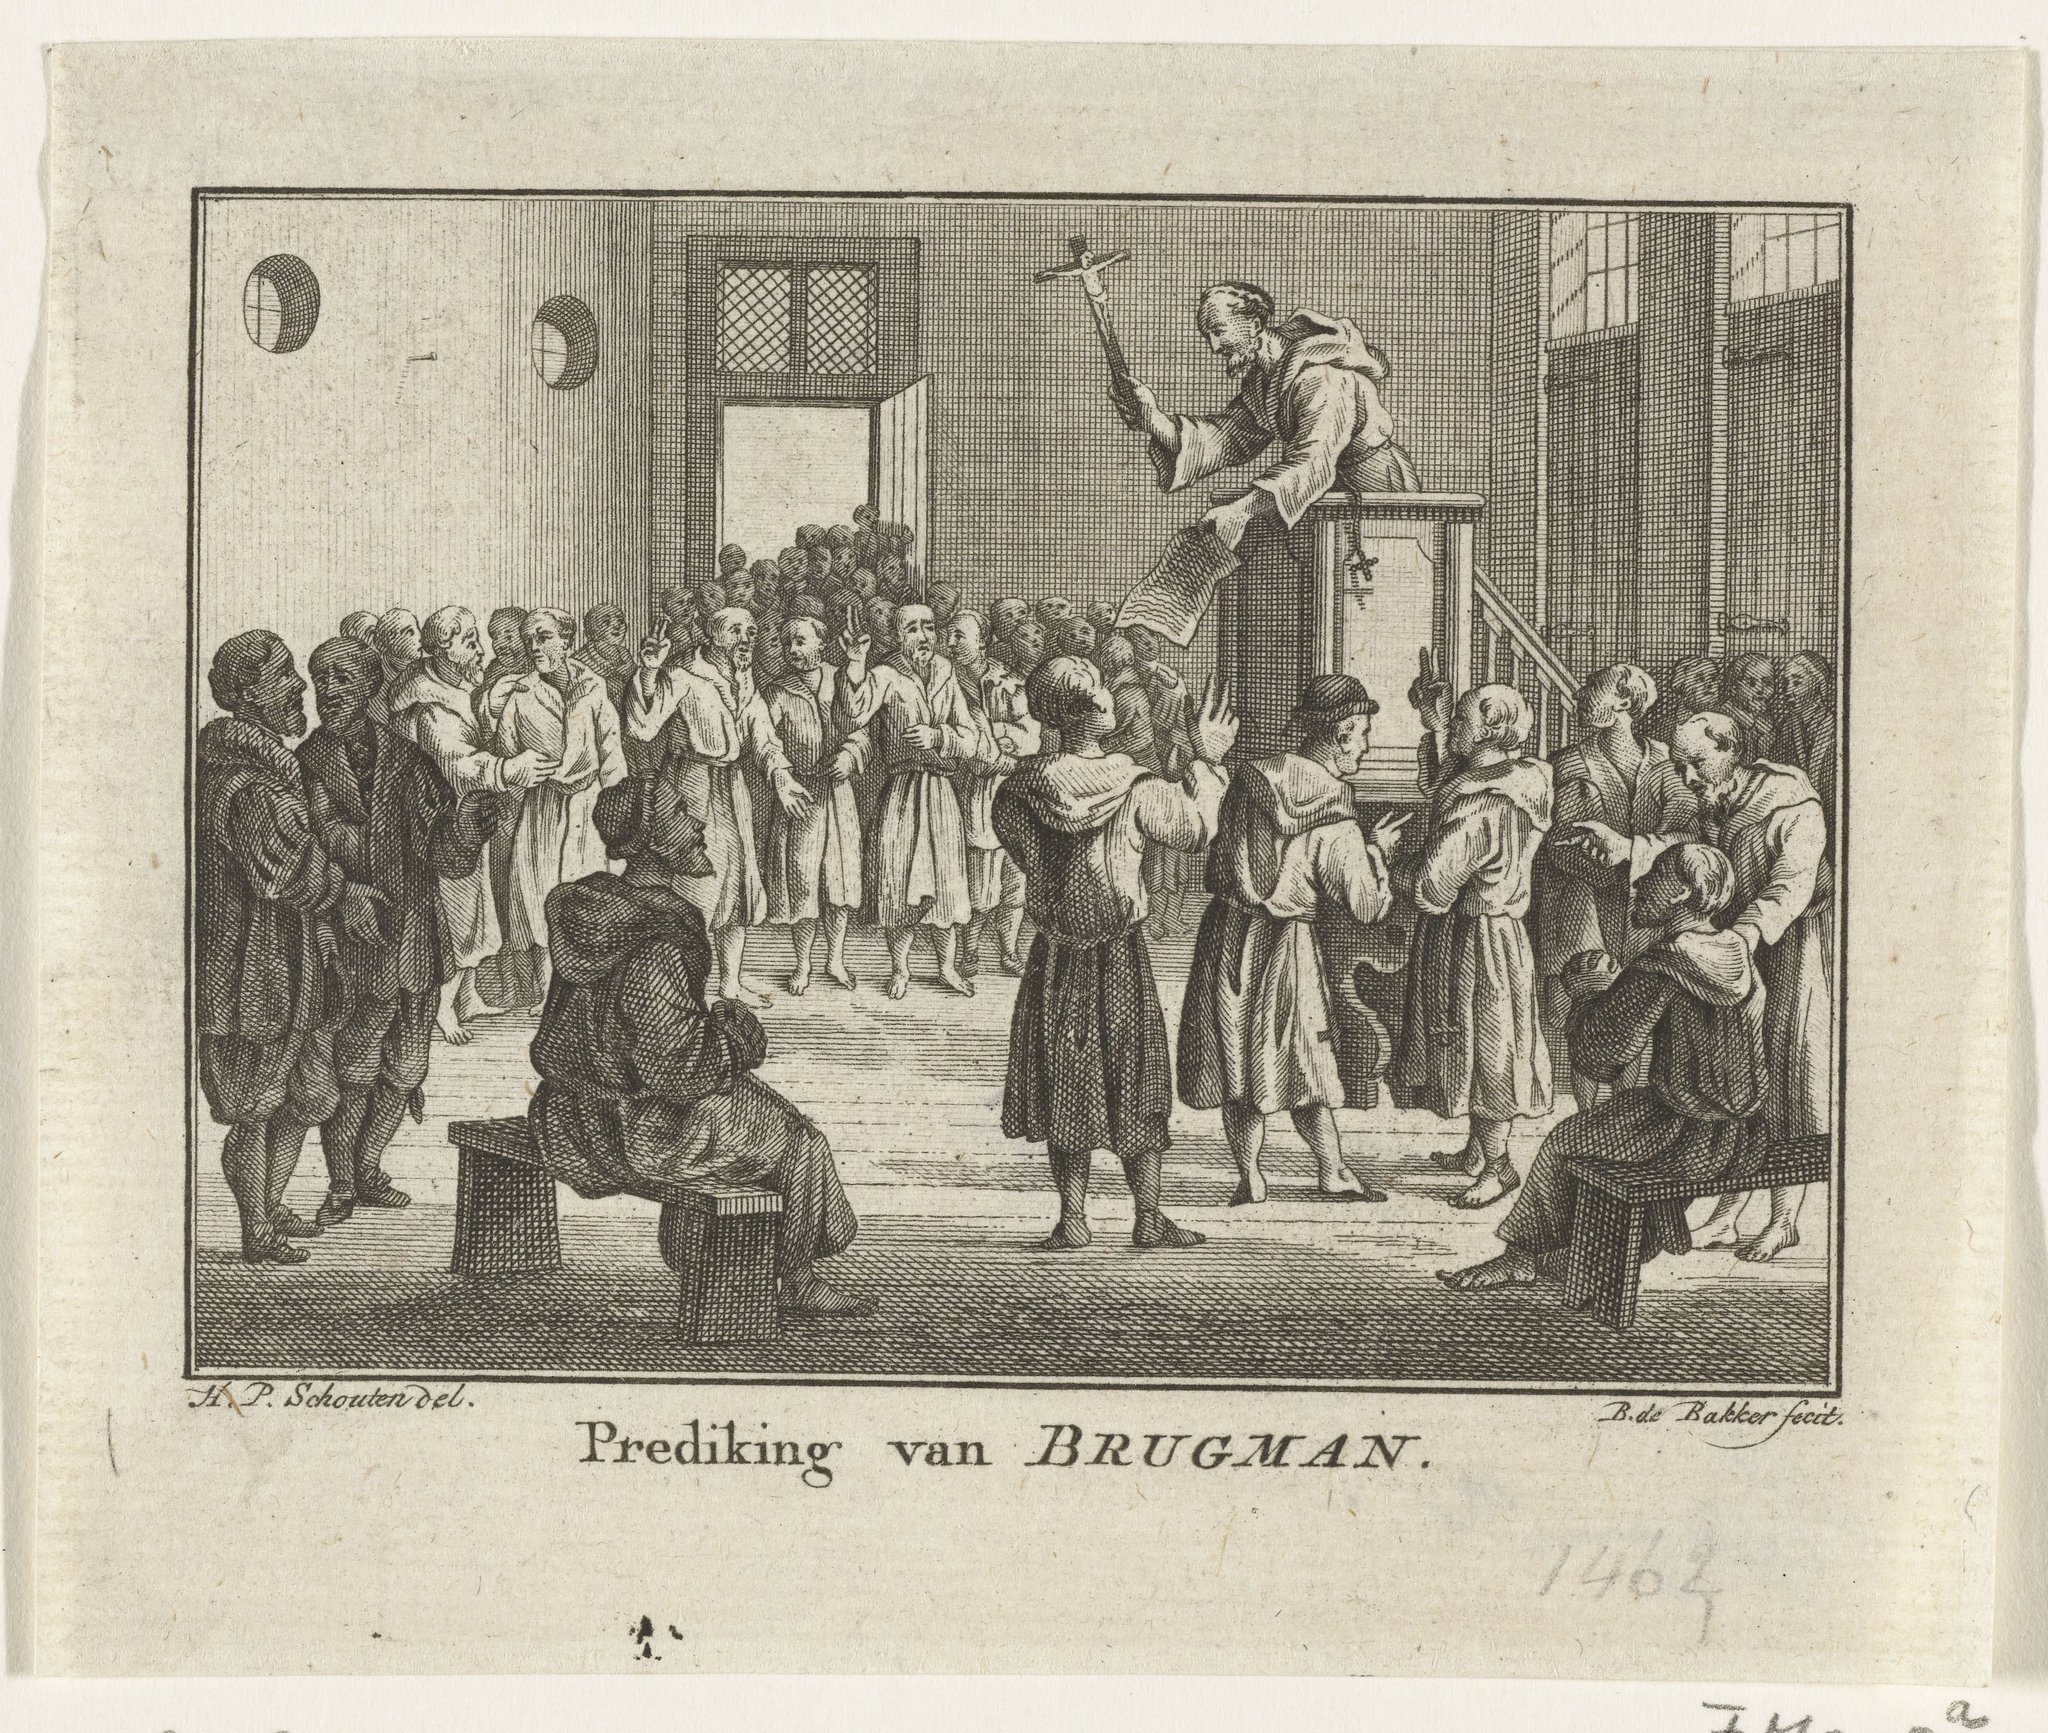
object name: print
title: Prediking van Brugman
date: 1780-1782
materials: paper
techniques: etching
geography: northern netherlands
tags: preaching (in general), netherlands, burgundian netherlands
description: Illustratie voor: L. van Ollefen, Verkorte beschryving van Amsteldam, geschikt voor de opvoeding der jeugd, J.B. Elwe, Amsterdam 1782. Staat met de letter.